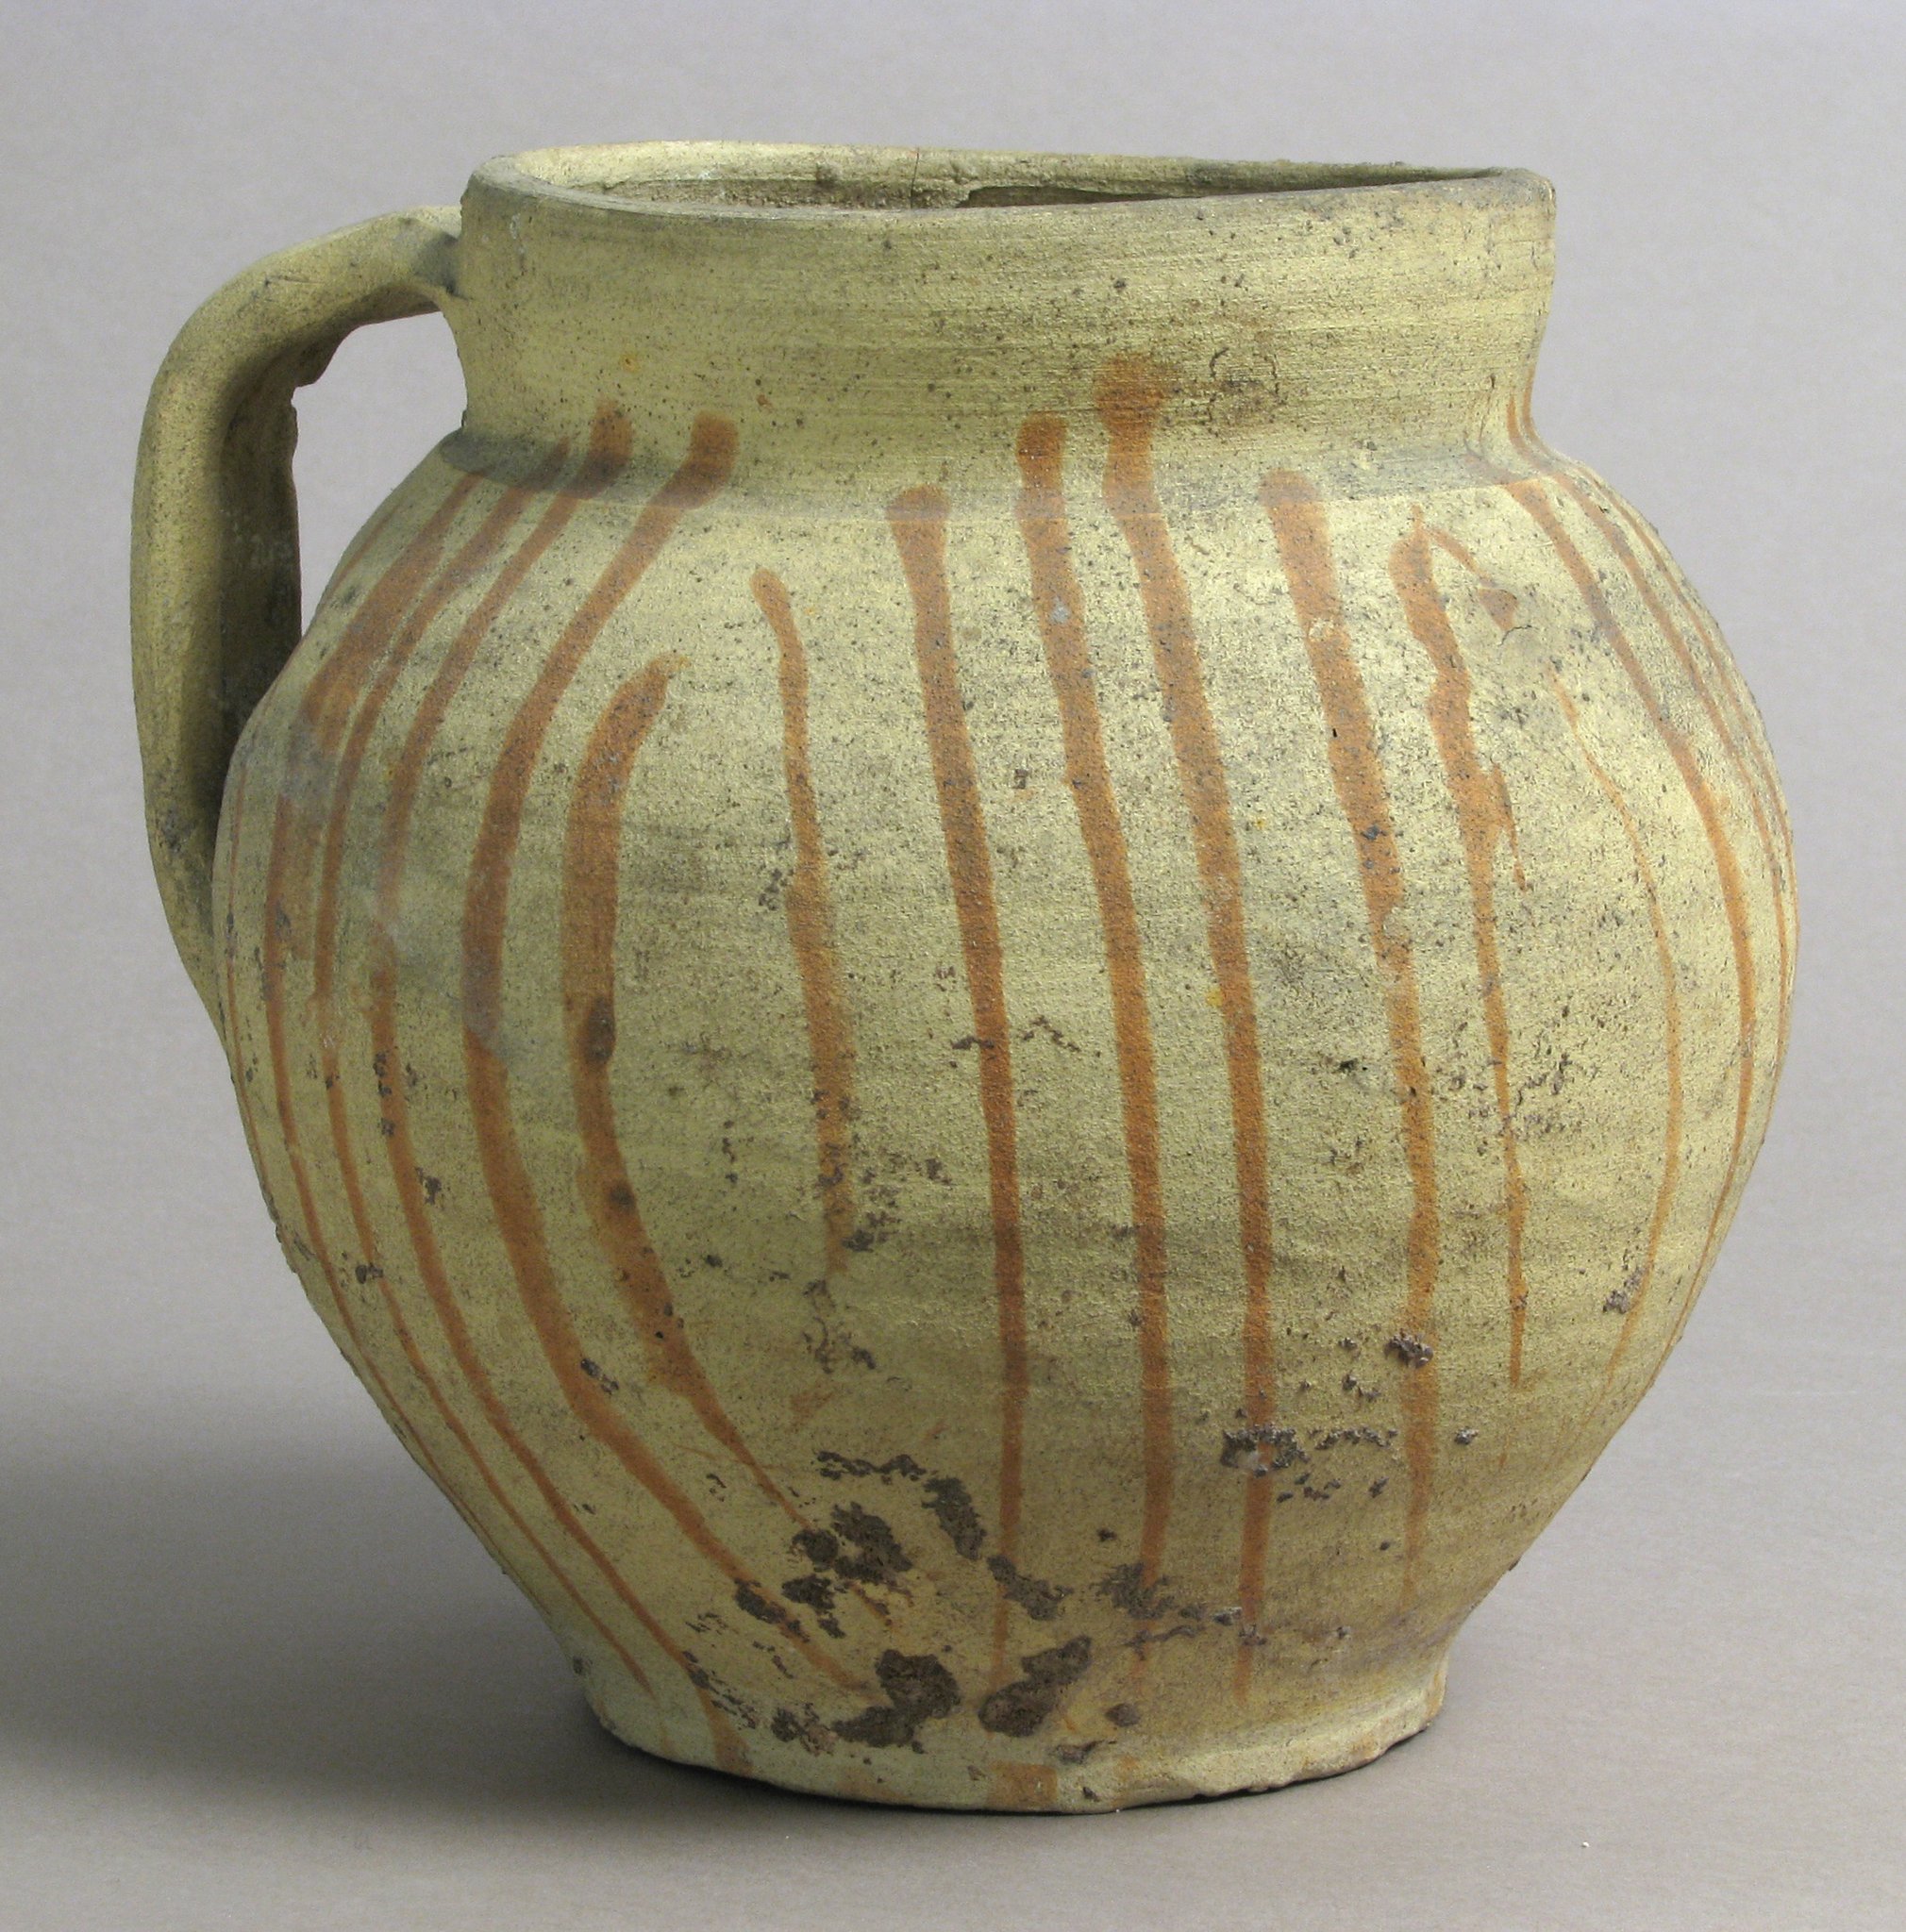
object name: jar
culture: french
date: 1201-1400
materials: earthenware